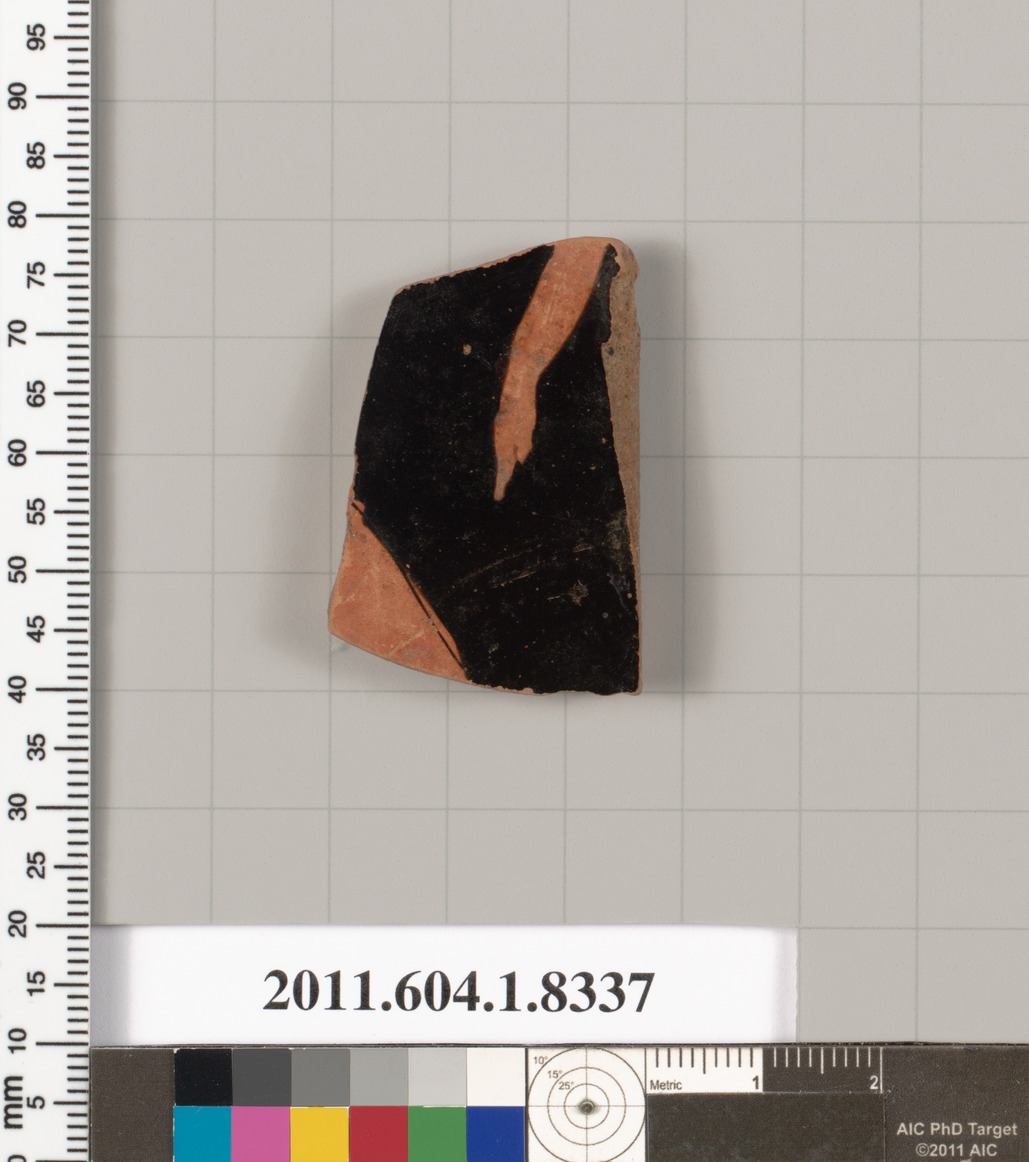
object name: kylix fragment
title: Terracotta fragment of a kylix (drinking cup)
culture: greek, attic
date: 400-376 BCE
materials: terracotta